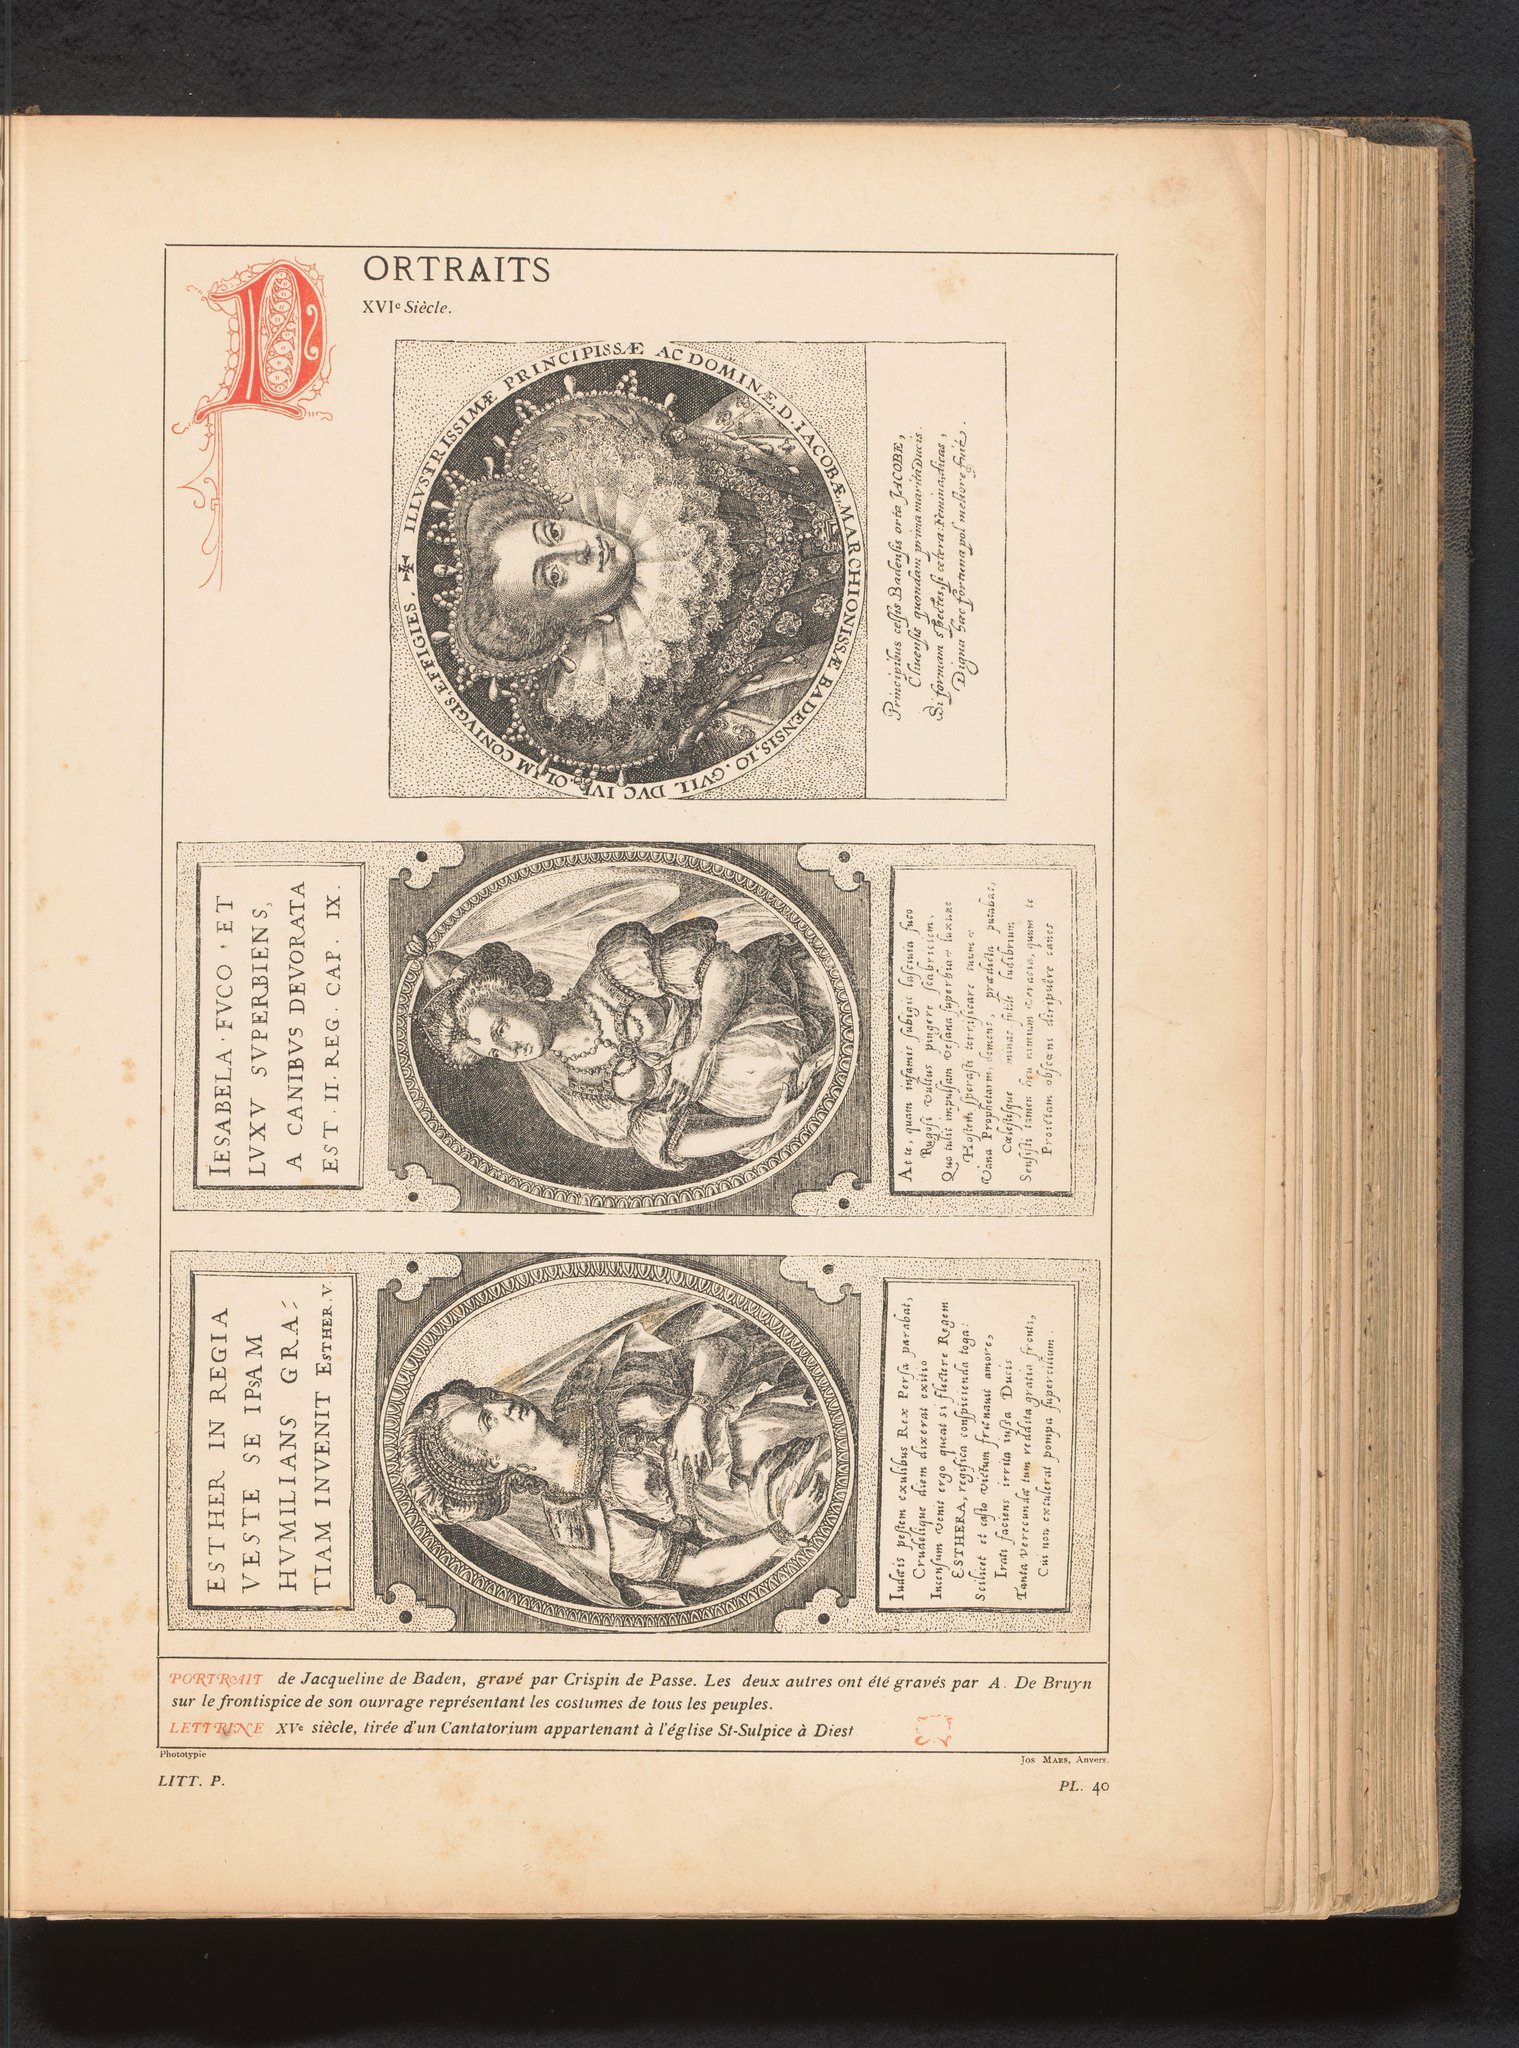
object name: photomechanical print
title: Portraits, XVIe Siècle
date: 1876-1881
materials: paper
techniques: photolithography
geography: antwerp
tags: adult man, historical persons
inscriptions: inscription: ‘LITT. P. - PL. 40.’, inscription: ‘PORTRAIT de Jaqueline de Baden (...)’, monogram: ‘JJvY’